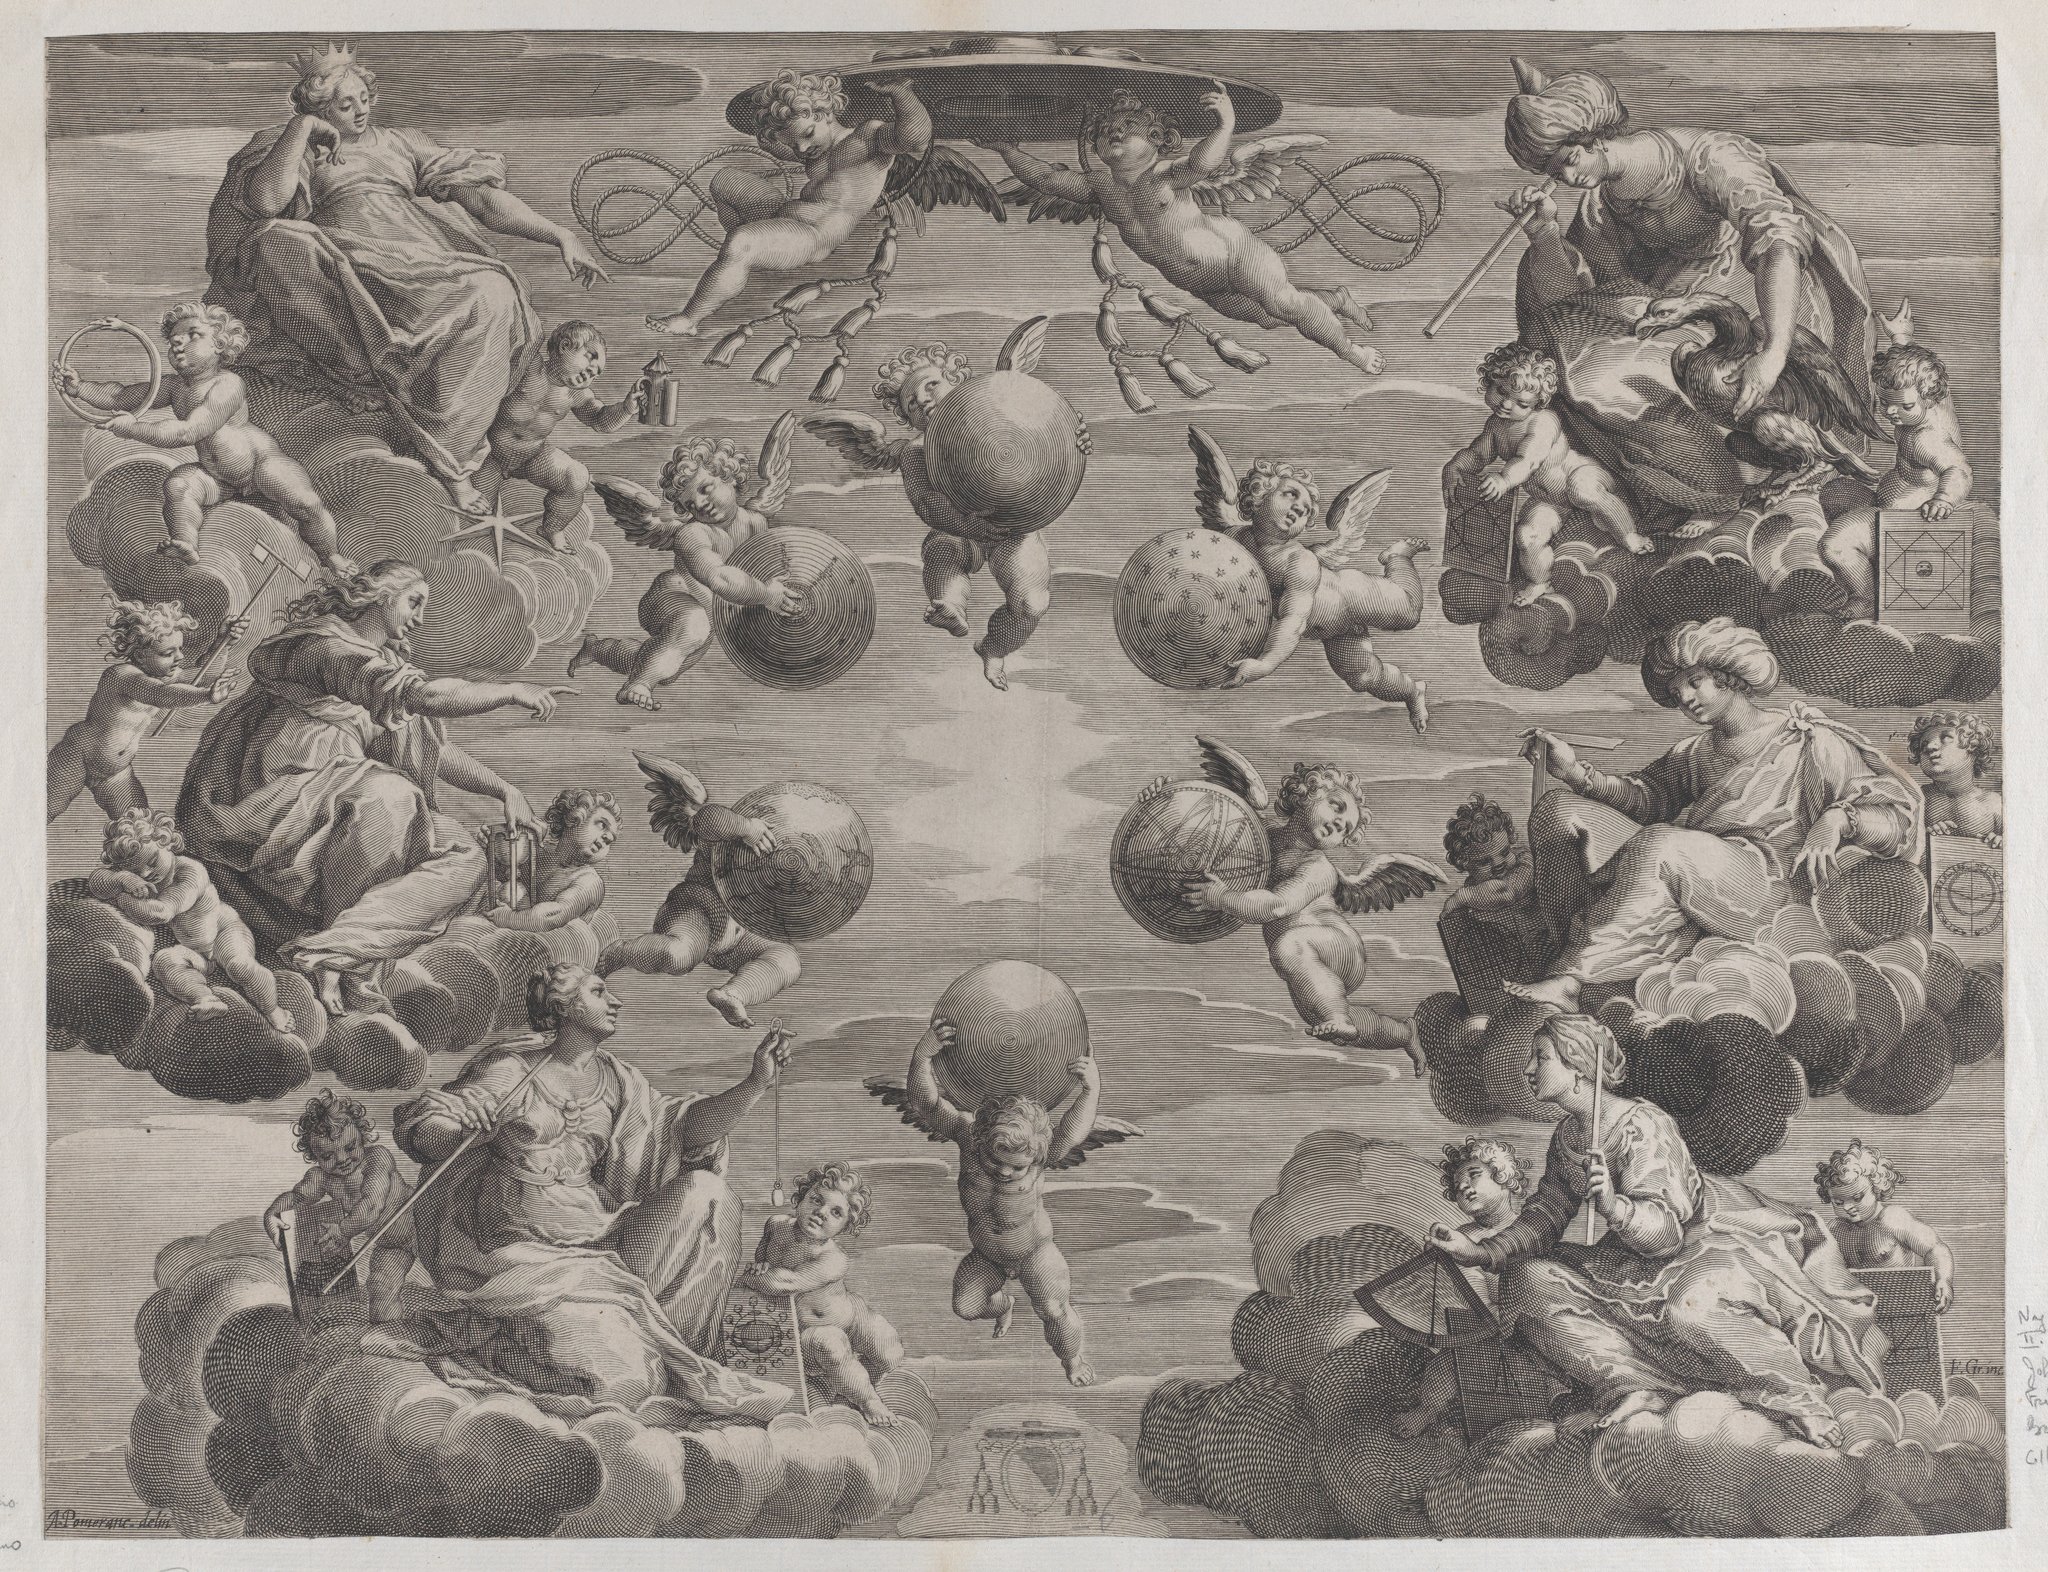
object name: print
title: Allegory relating to the Medici family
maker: johann friedrich greuter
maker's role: artist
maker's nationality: german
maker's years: 1590-1662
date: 1610-1662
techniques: engraving